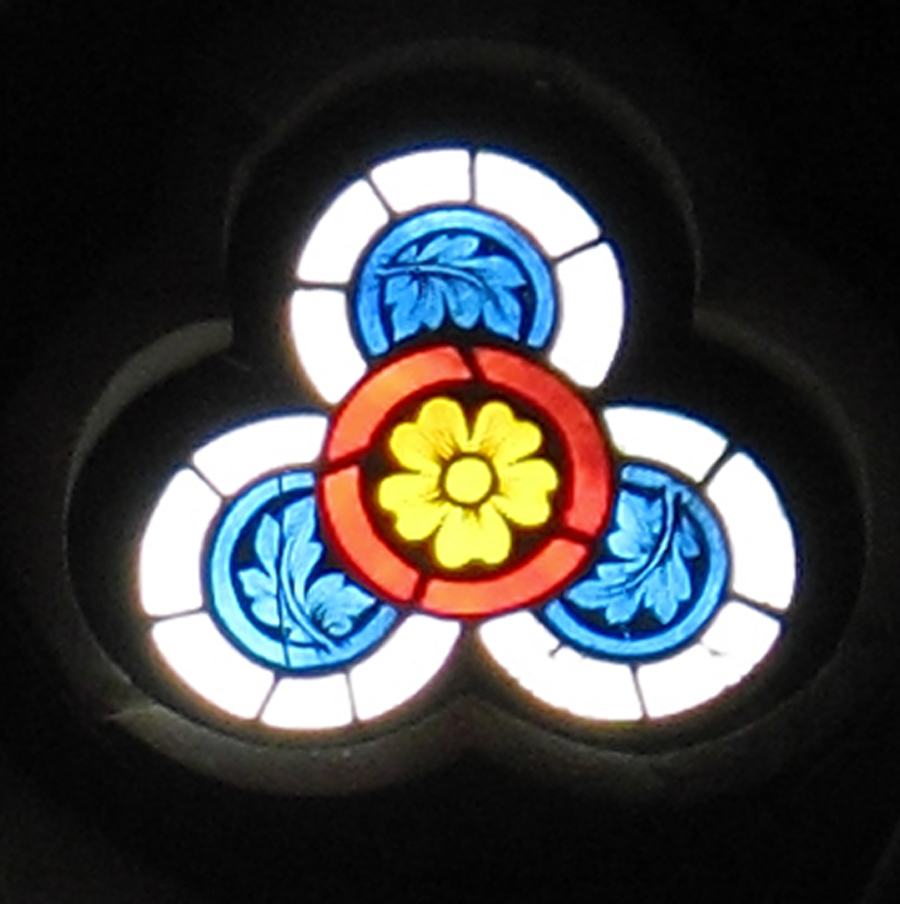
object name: tracery light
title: Trefoil-shaped Tracery Light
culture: austrian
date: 1340-1350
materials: glass, metal, paint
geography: austria